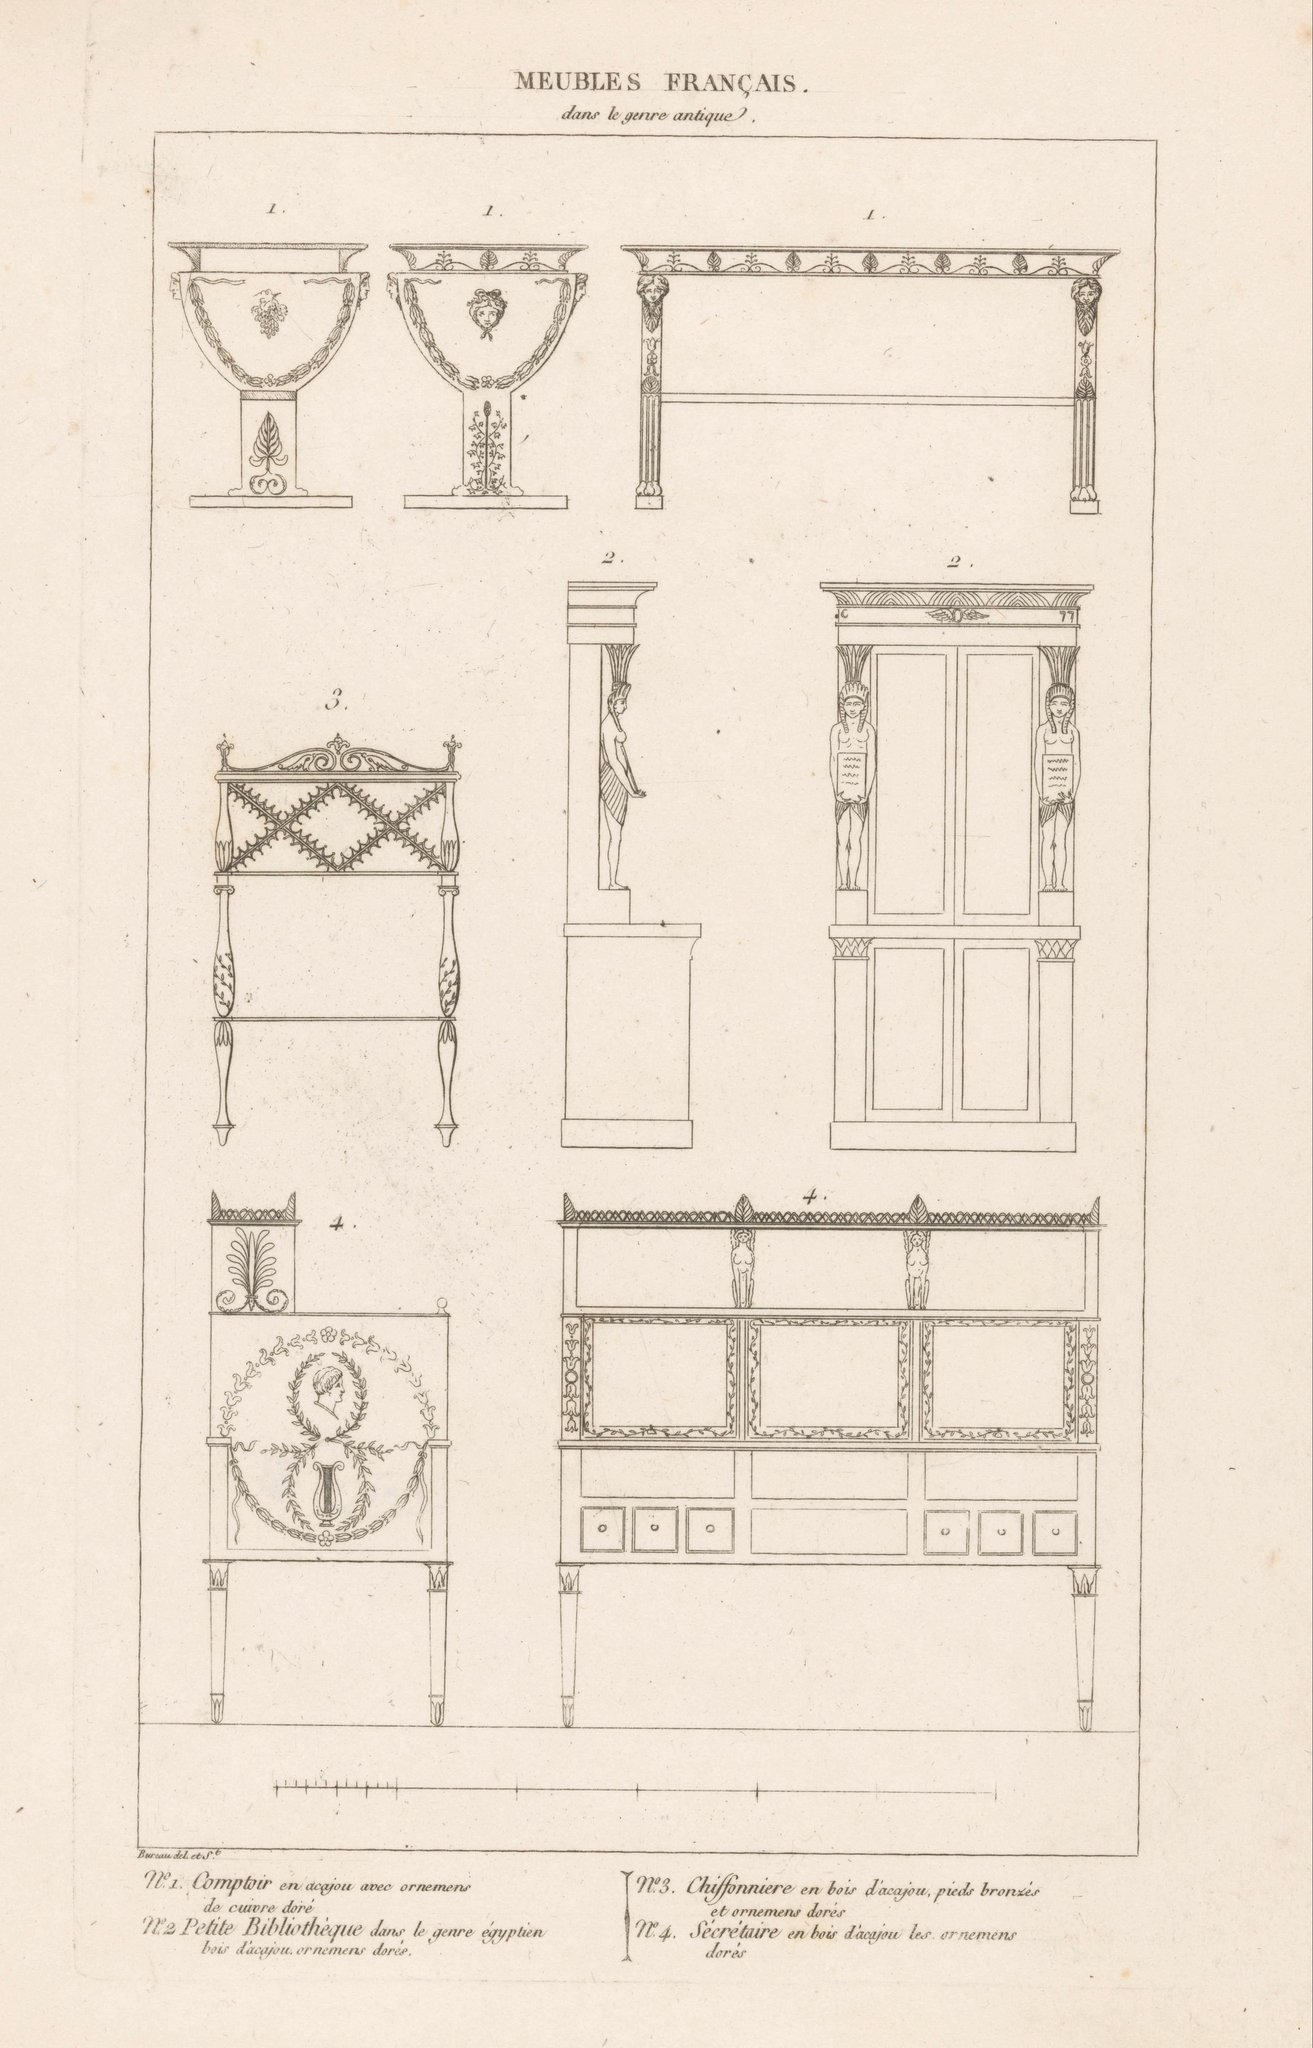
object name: print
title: Meubles Français dans le genre antique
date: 1815-1825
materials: paper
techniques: etching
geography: france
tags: furniture for storage, furniture to put things on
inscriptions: collector's mark: Lugt 2228, collector's mark: Lugt 2760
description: Voor- en zijaanzicht van vier empire meubelen zoals een hoge, smalle tafel, een boekenkast en een secretaire. In de ondermarge een Franse beschrijving.